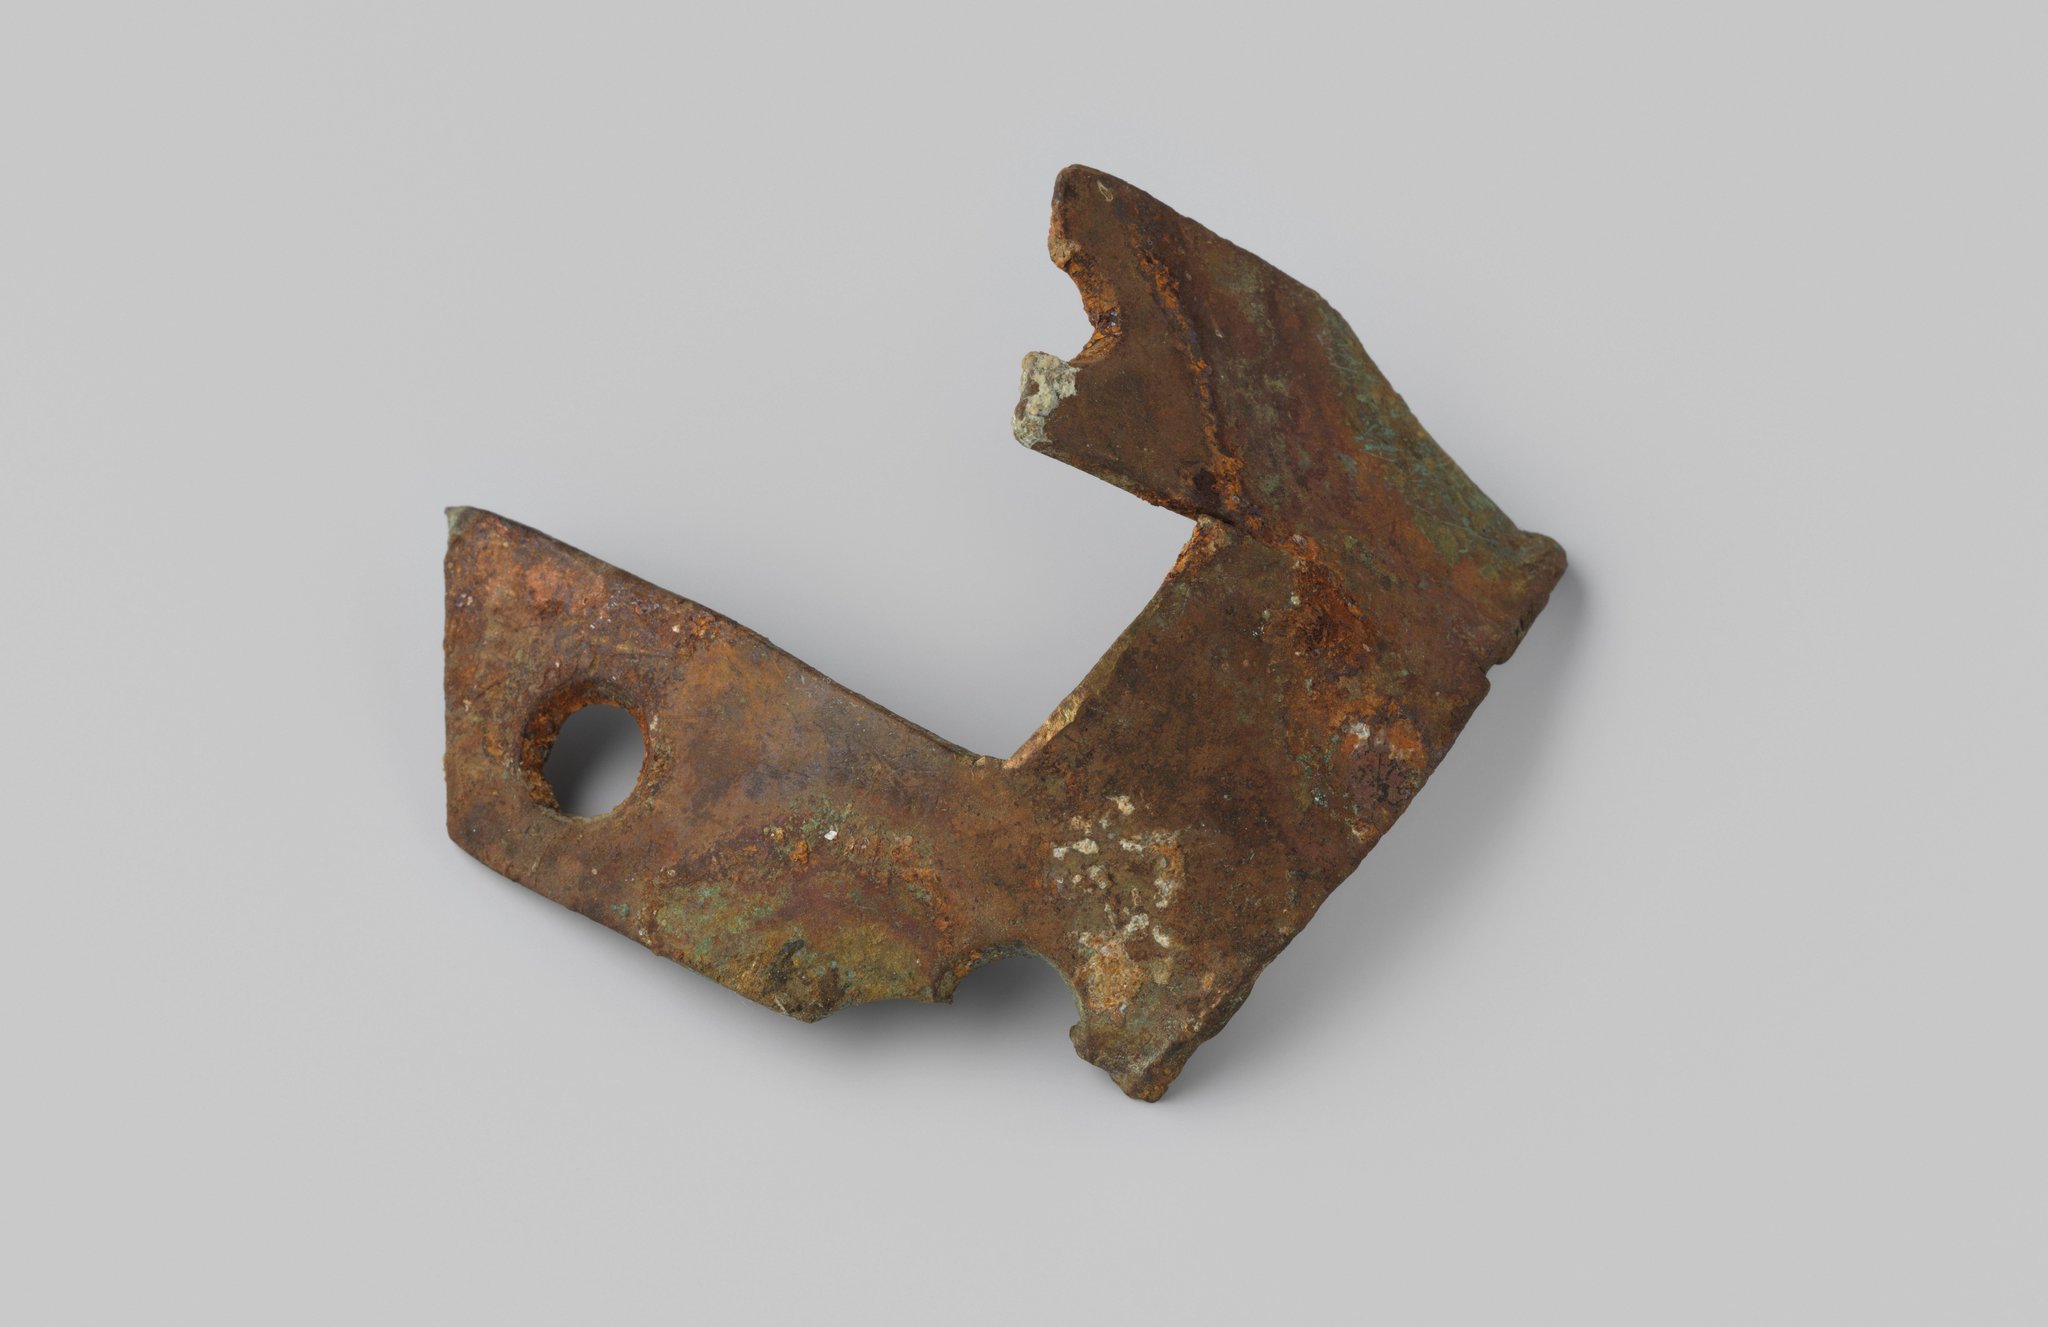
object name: part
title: Onderdeel of hulpstuk afkomstig uit het wrak van de Oost-Indiëvaarder Hollandia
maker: Anonymous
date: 1700-1743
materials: copper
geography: netherlands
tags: verenigde oostindische compagnie, hollandia (schip)